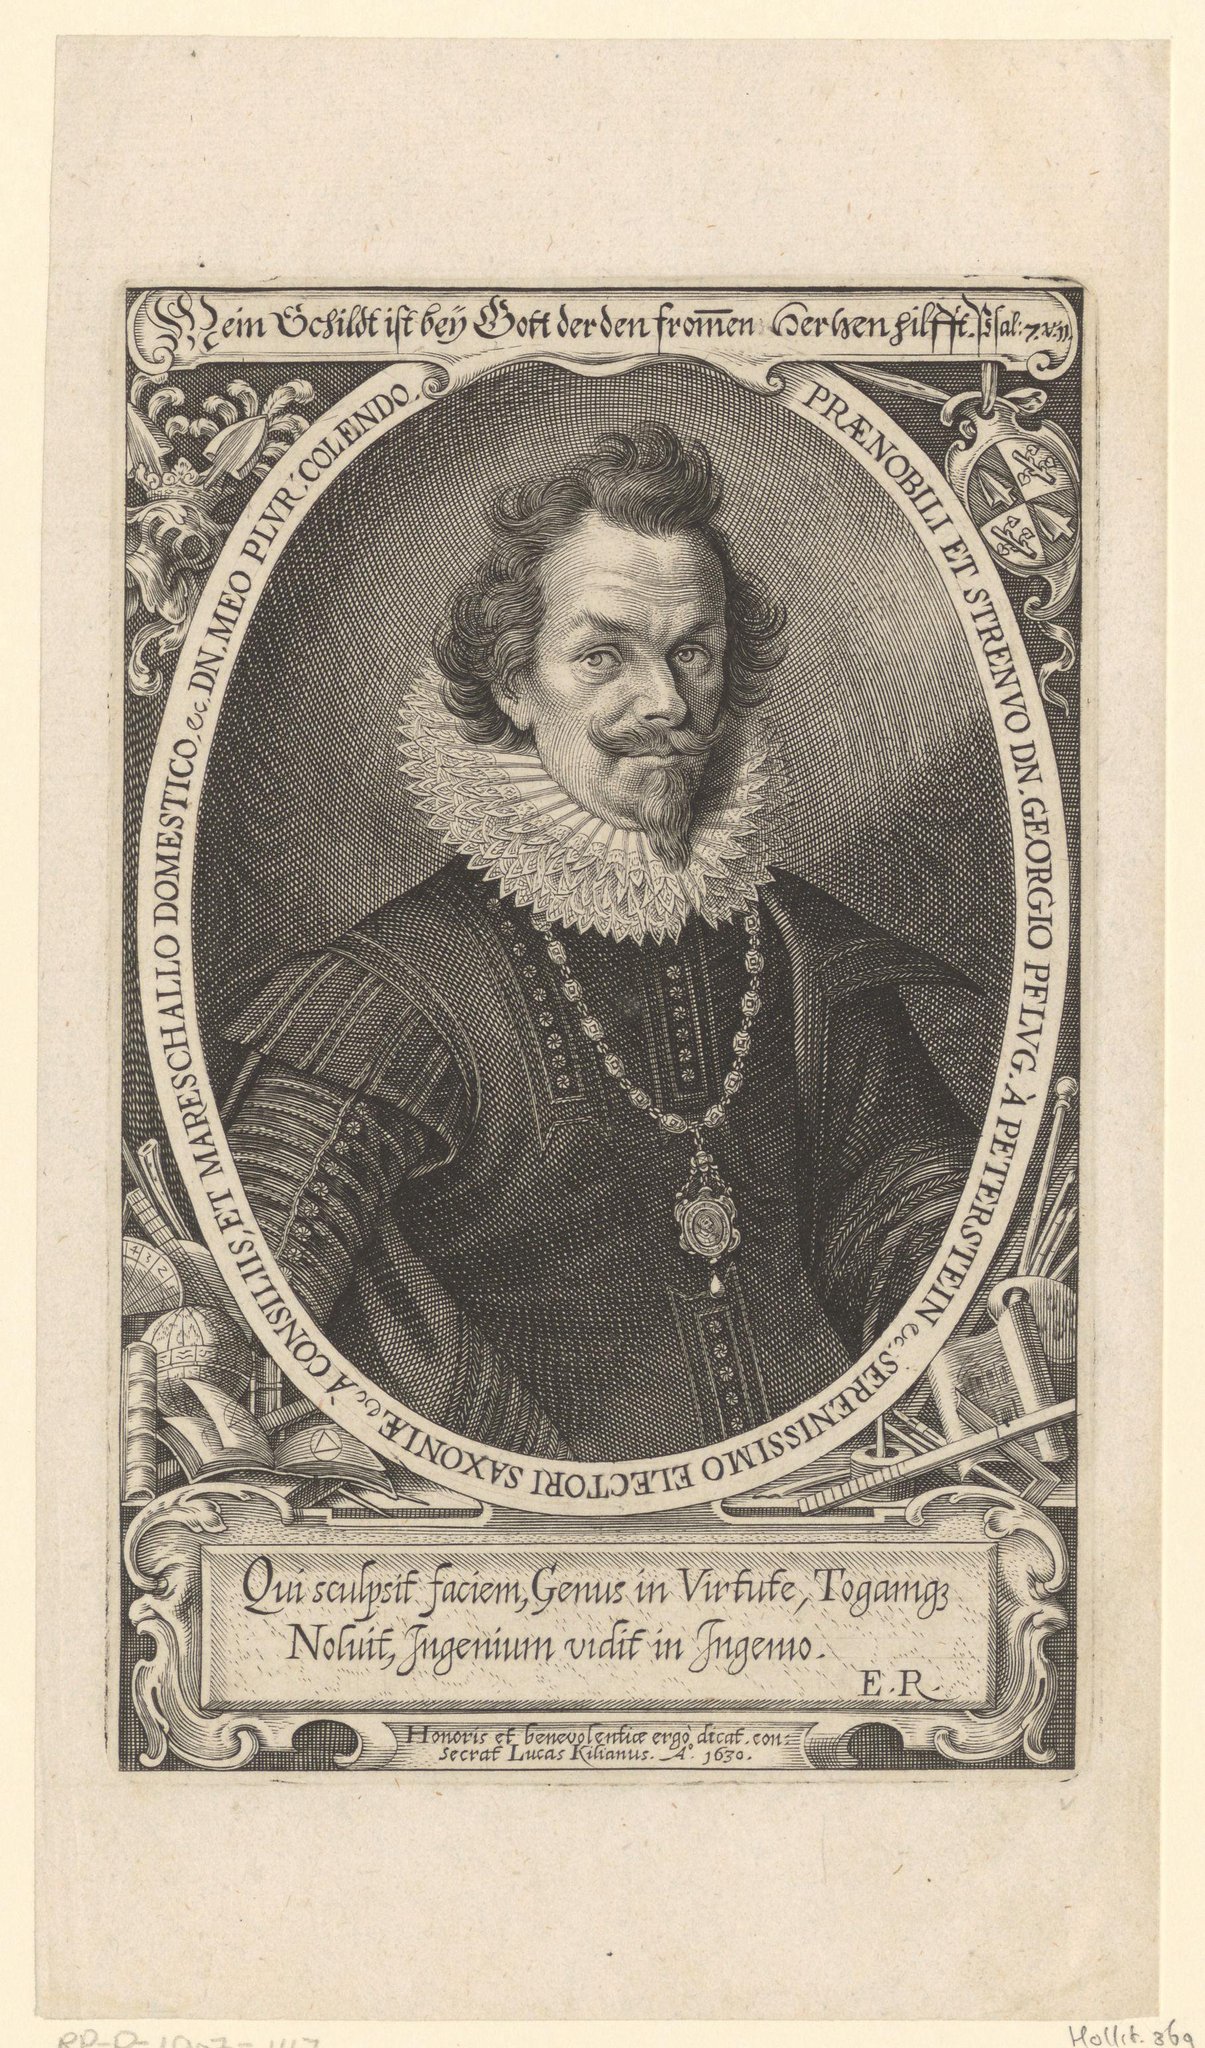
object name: print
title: Portret van Georg Pflug von Peterstein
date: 1630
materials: paper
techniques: engraving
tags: georg pflug von peterstein, historical persons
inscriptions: collector's mark: Lugt 2228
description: Tekst in het Latijn in de omlijsting en in de ondermarge.